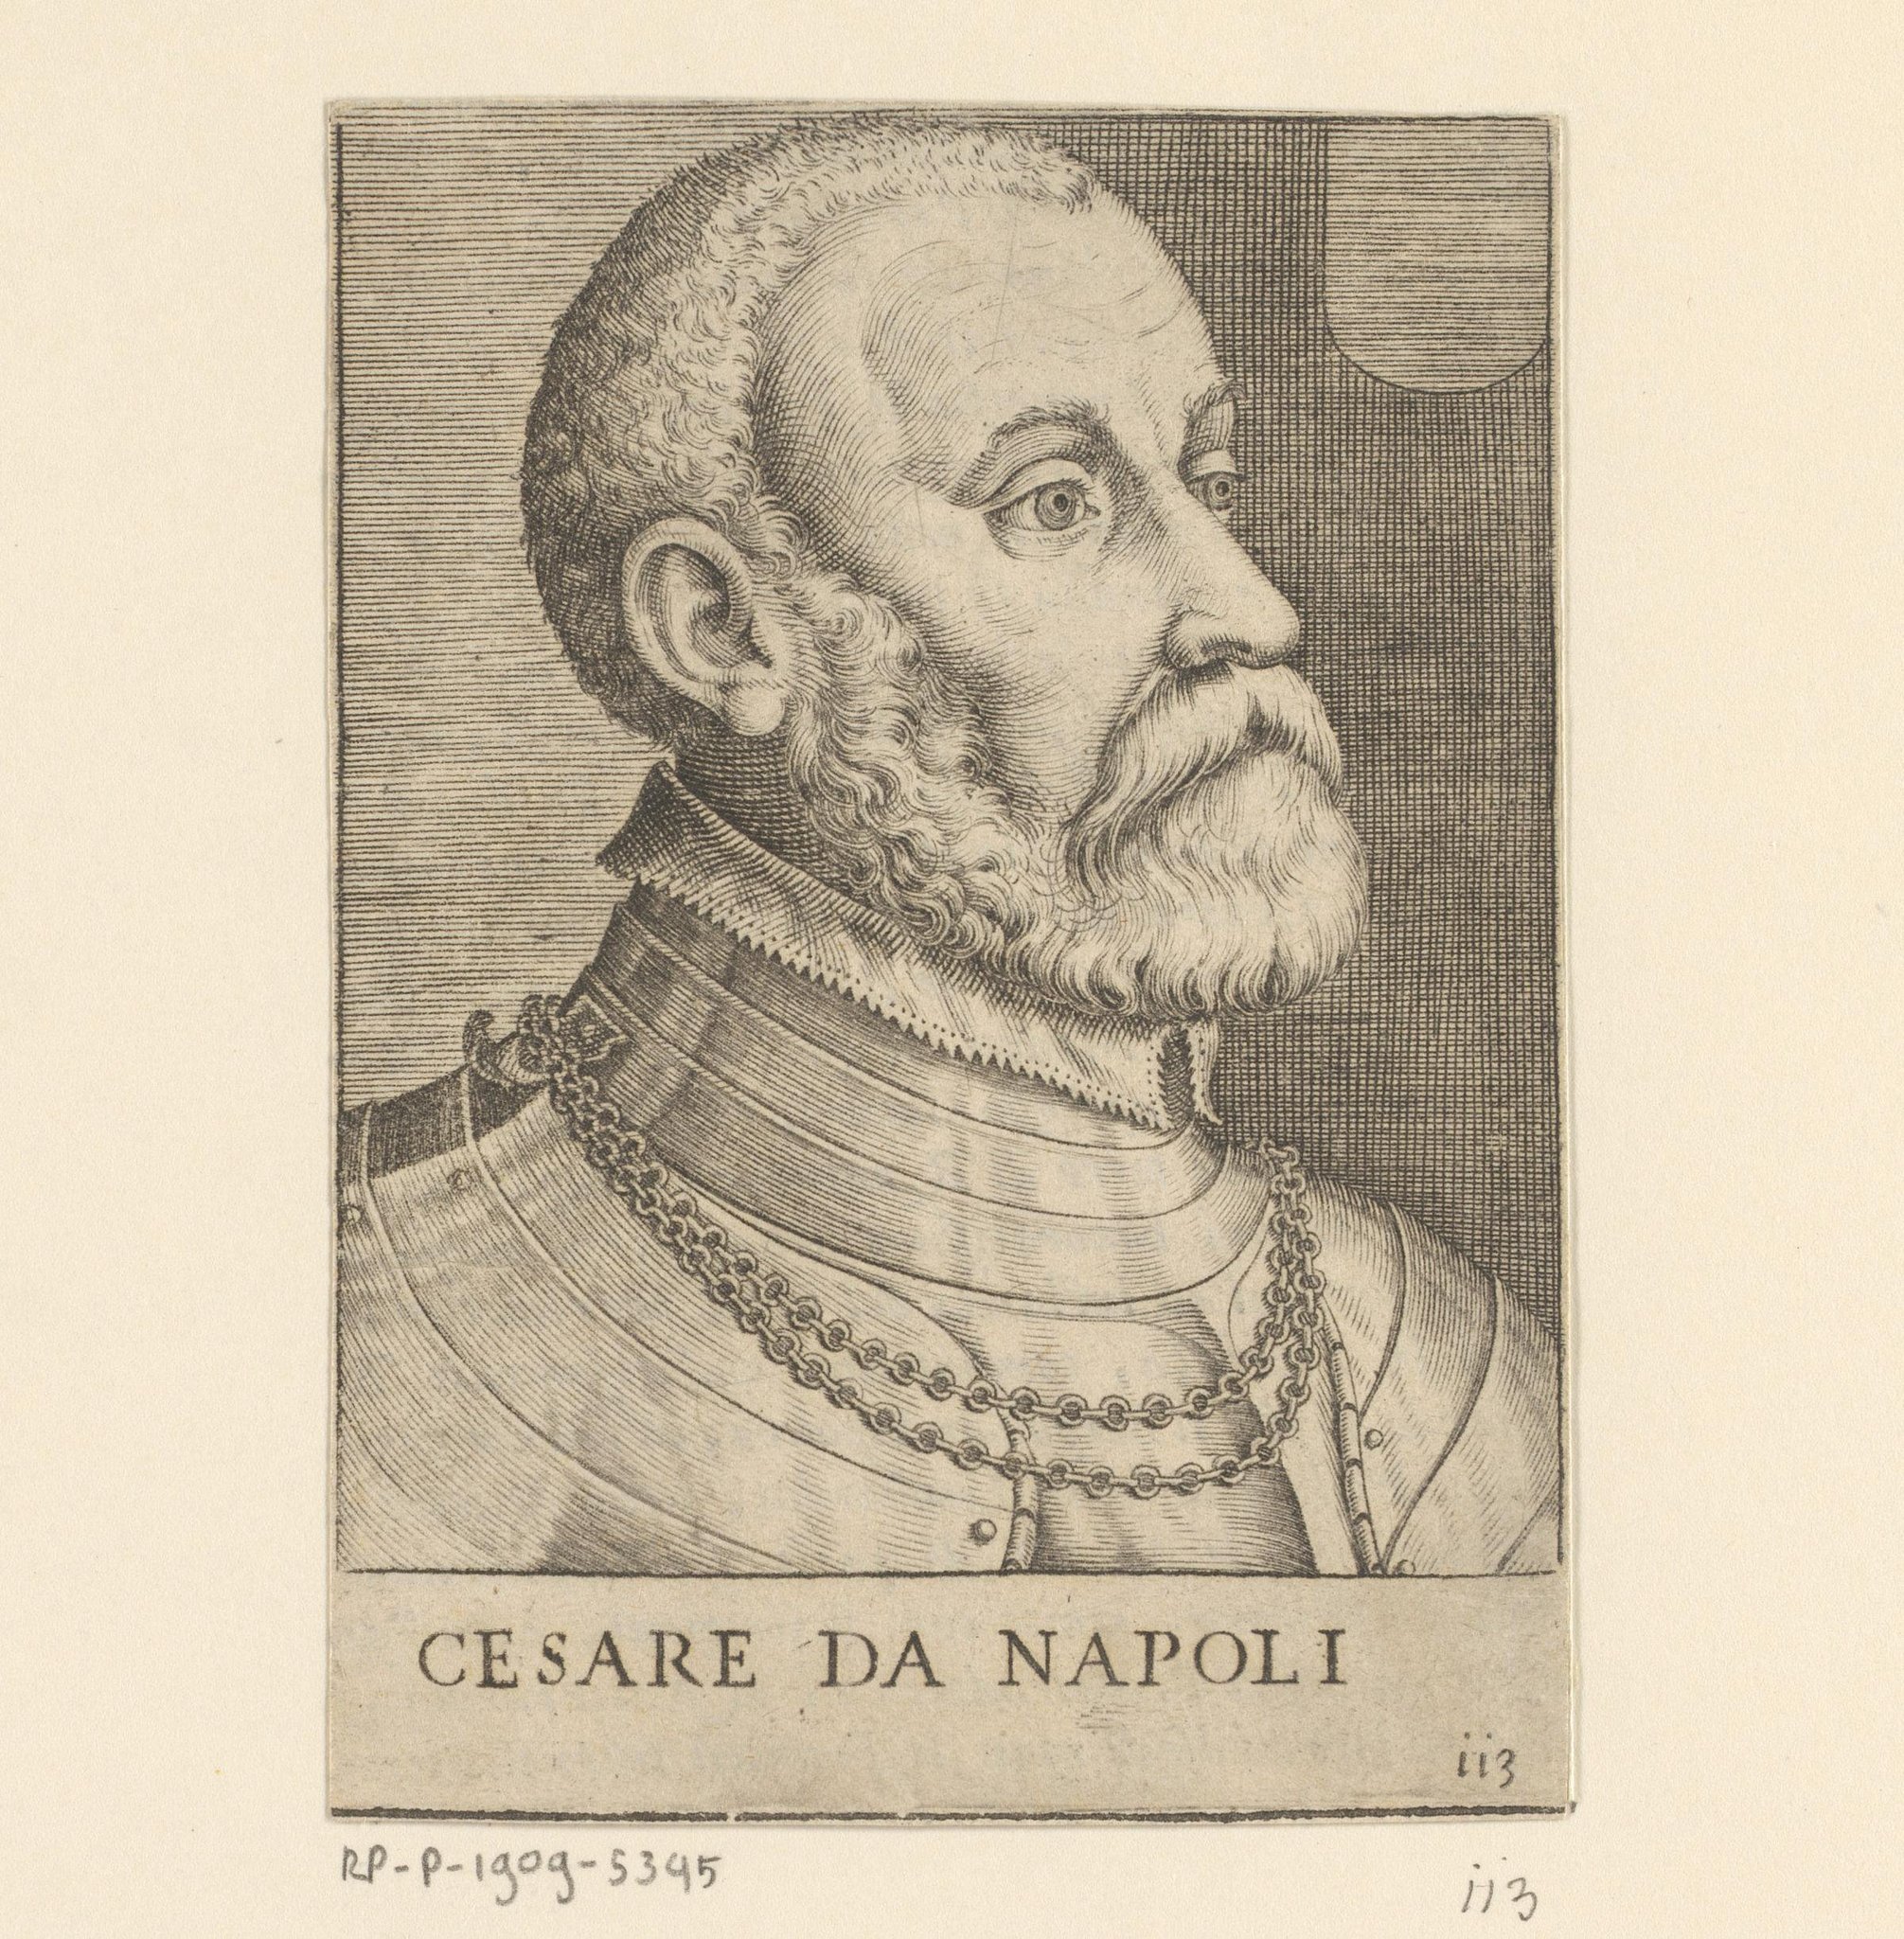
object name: book illustration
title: Cesare da Napoli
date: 1635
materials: paper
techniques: engraving, letterpress printing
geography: rome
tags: naples, commander-in-chief, general, marshal, historical persons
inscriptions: collector's mark: Lugt 2228, inscription: ‘N21471 [...]’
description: Prent uit: Ritratti et elogii di capitani Illustri. Rome: Pompilio Totti en Andrea Fei, 1635, p. 249. Eerdere staat van prent in ieder geval ook gebruikt in: Ritratti di cento capitani illustri con li lor Fatti in guerra (…), Rome: Domenico Gigliotti, 1596. Latere staat van prent in ieder geval ook gebruikt in: Ritratti et elogii di capitani Illustri. Che ne'secoli moderni hanno gloriosamente guerreggiato. Rome: Filippo de'Rossi en Vitale Mascardi, 1646.